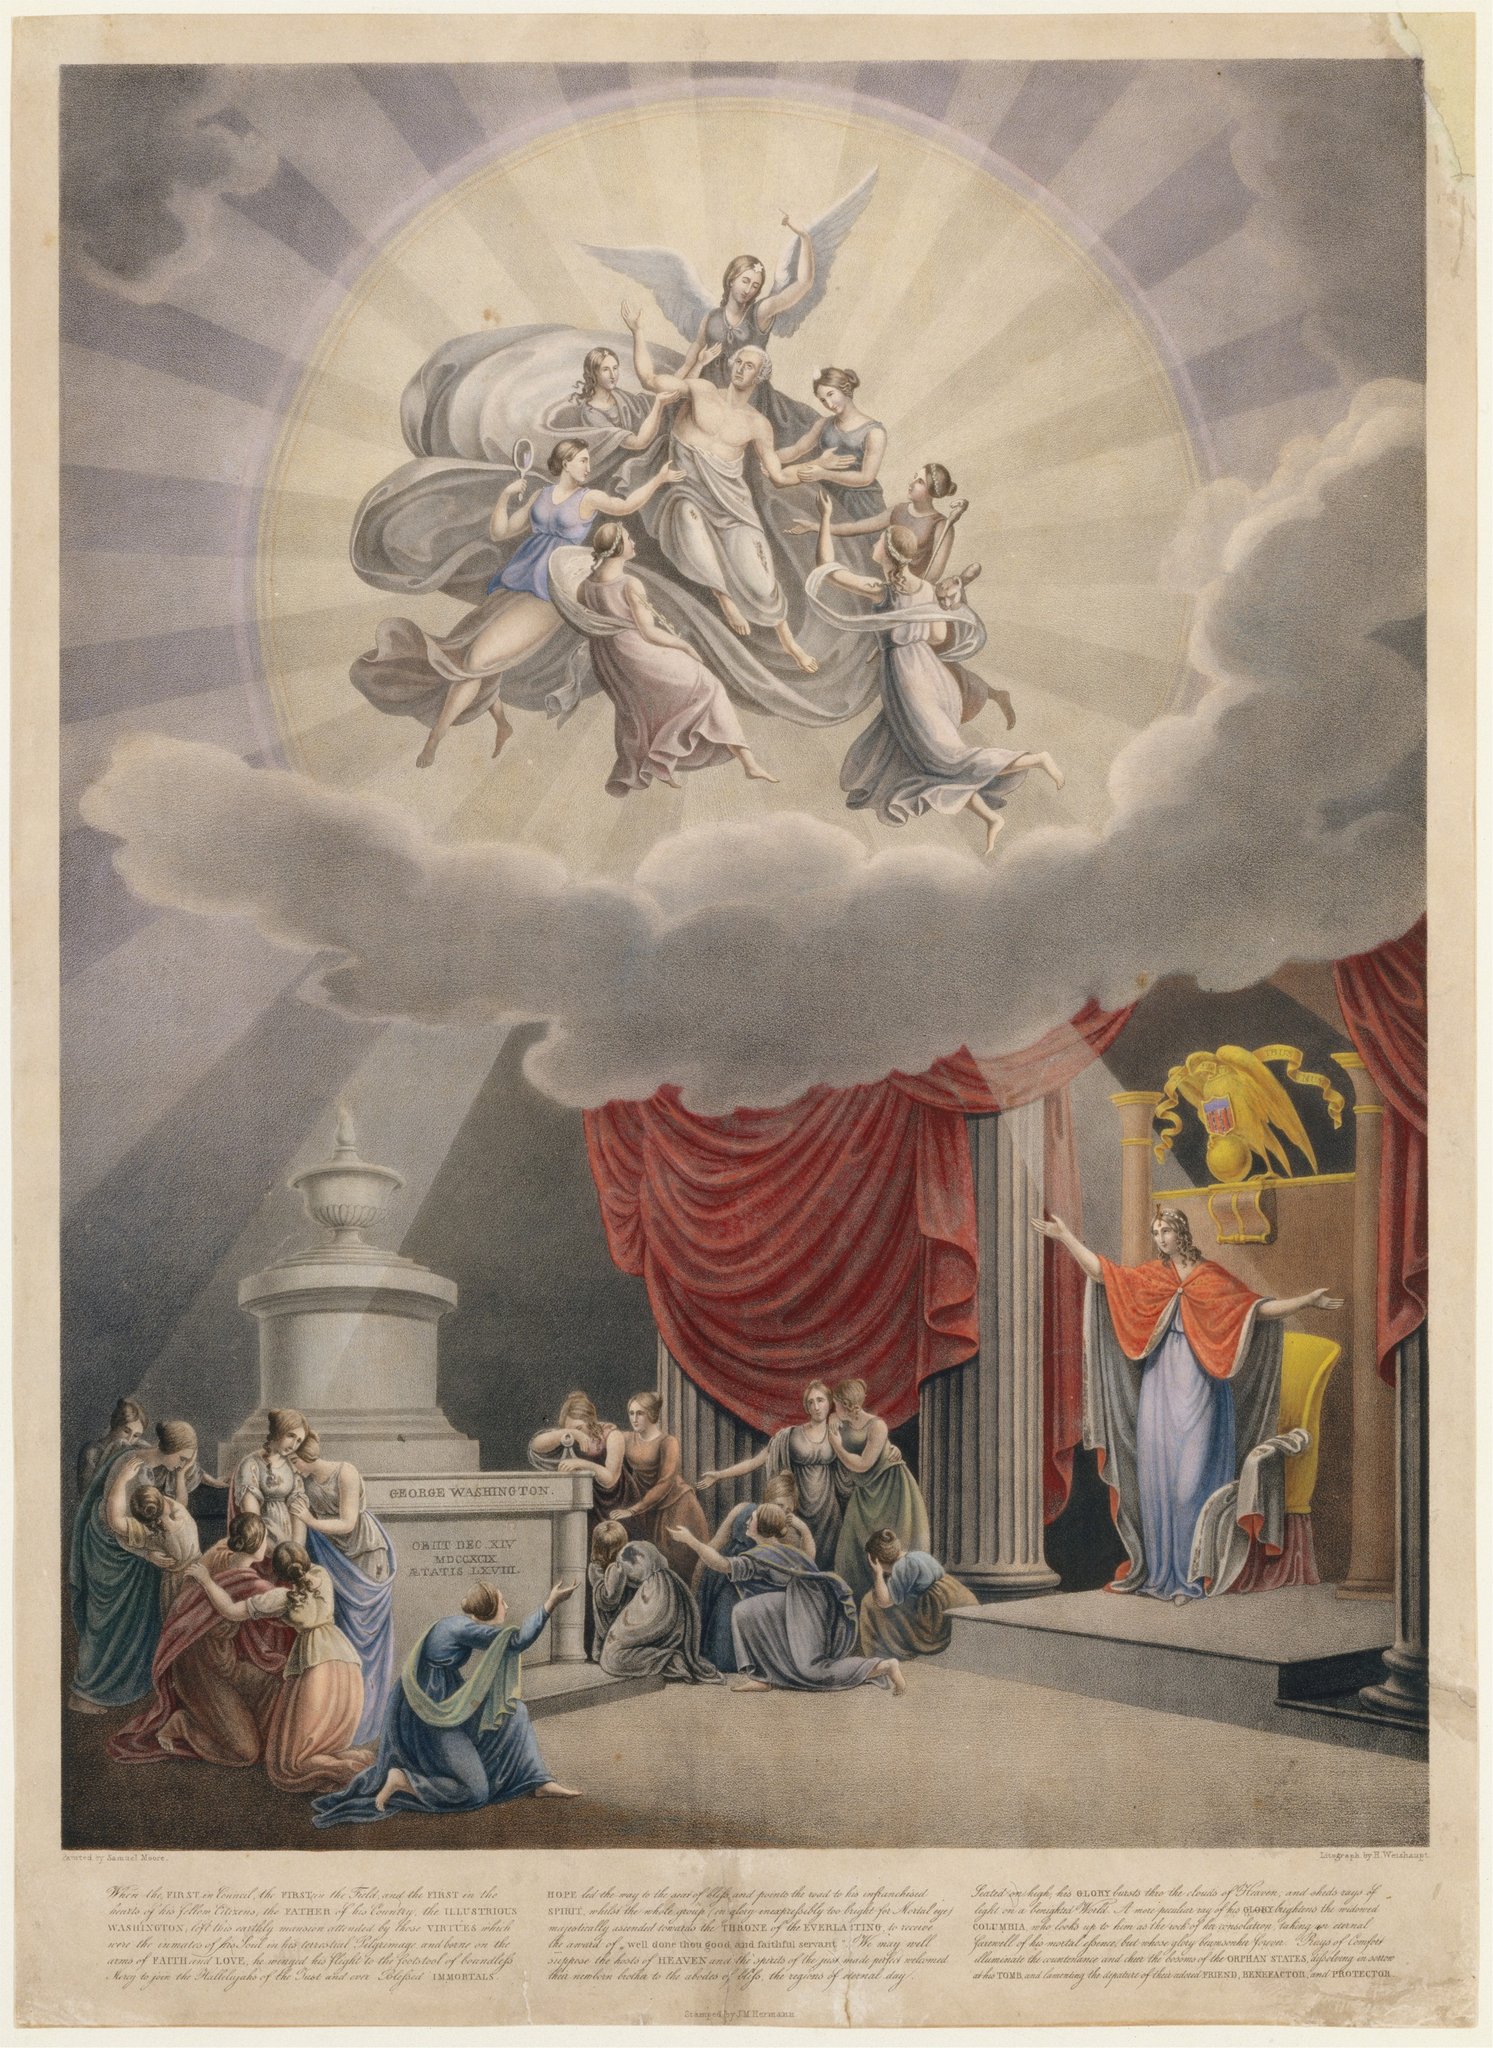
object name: print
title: Apotheosis of George Washington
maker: heinrich weishaupt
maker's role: lithographer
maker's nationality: german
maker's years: 1810-1883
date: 1830-1850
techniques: hand coloring, lithograph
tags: george washington,women,angels